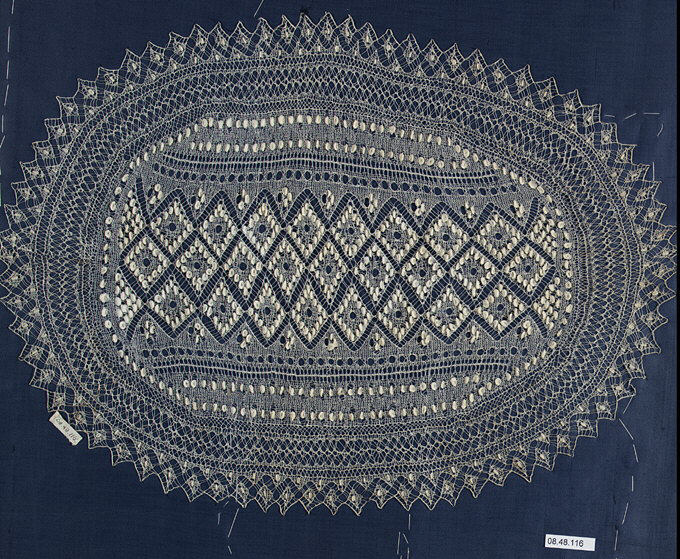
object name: mat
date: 1701-1800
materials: lace